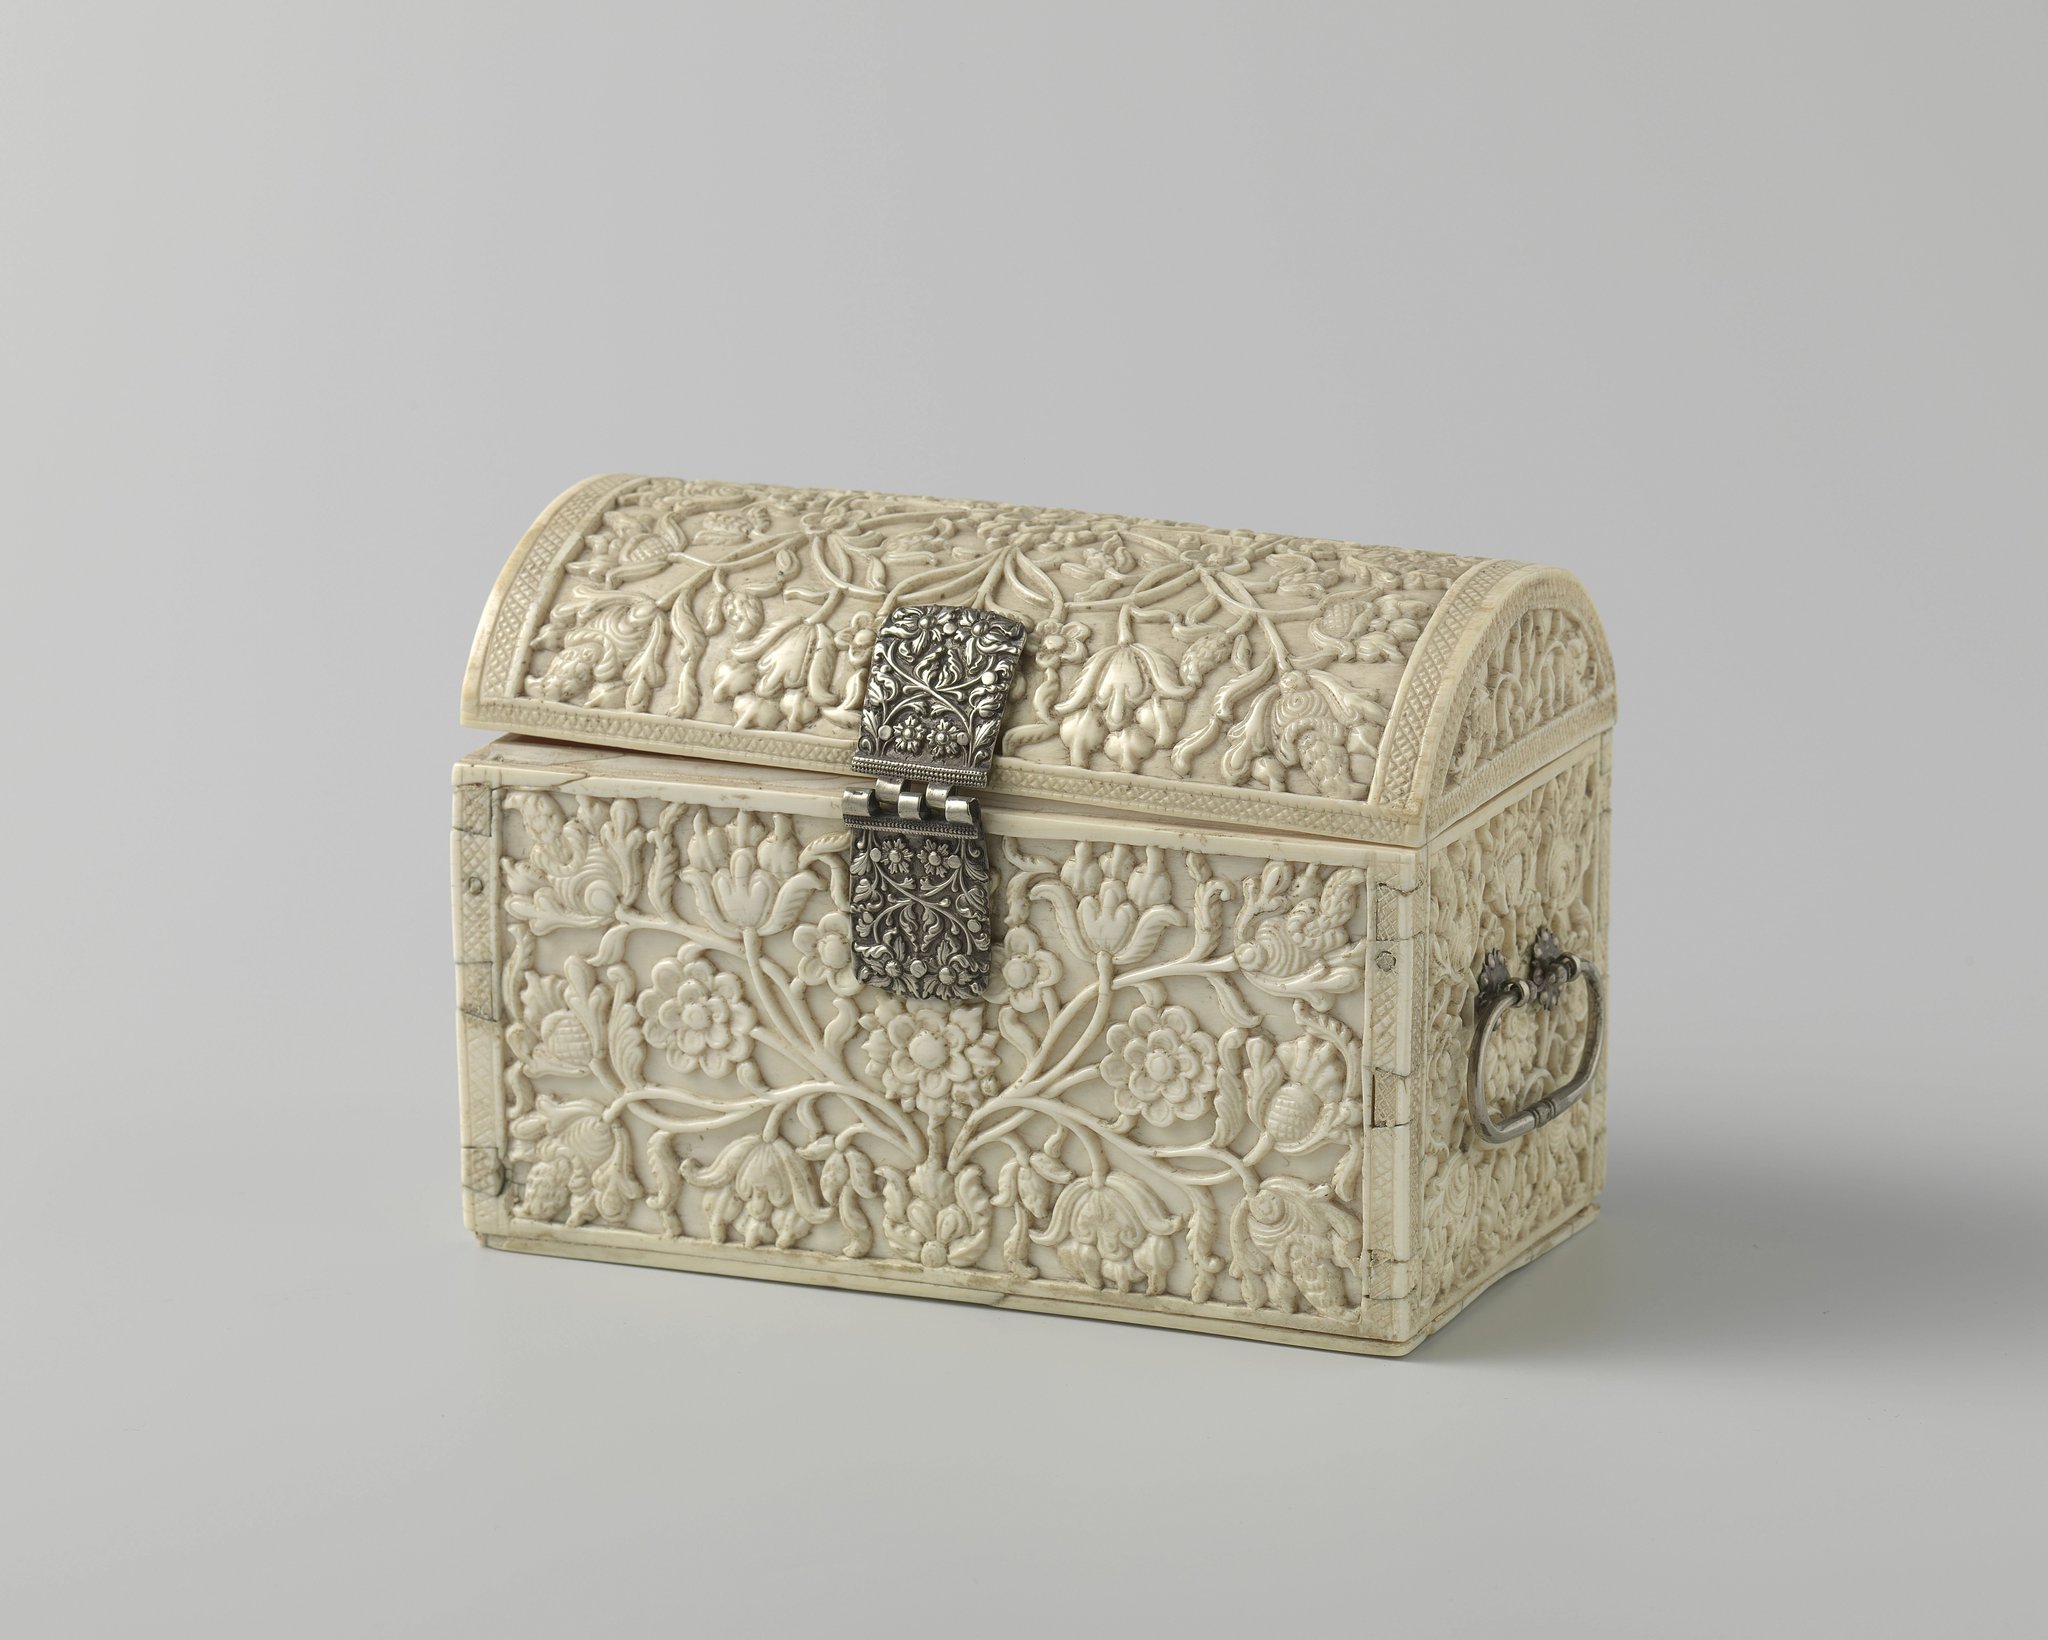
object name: jewel case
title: Chest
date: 1680-1700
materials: ivory, silver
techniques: cutting, engraving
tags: flowers ~ ornament, sri lanka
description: During the 17th and 18th centuries, Ceylon was renowned for its small, splendidly carved objects in wood and ivory. Wherease the large flowers derive in part from indigenous Asian decorative motifs, they were adapted to suit the taste of Dutch patrons. This little chest is comparable to the one depicted in the lap of one of the Cnoll daughters in the family portrait on view above.